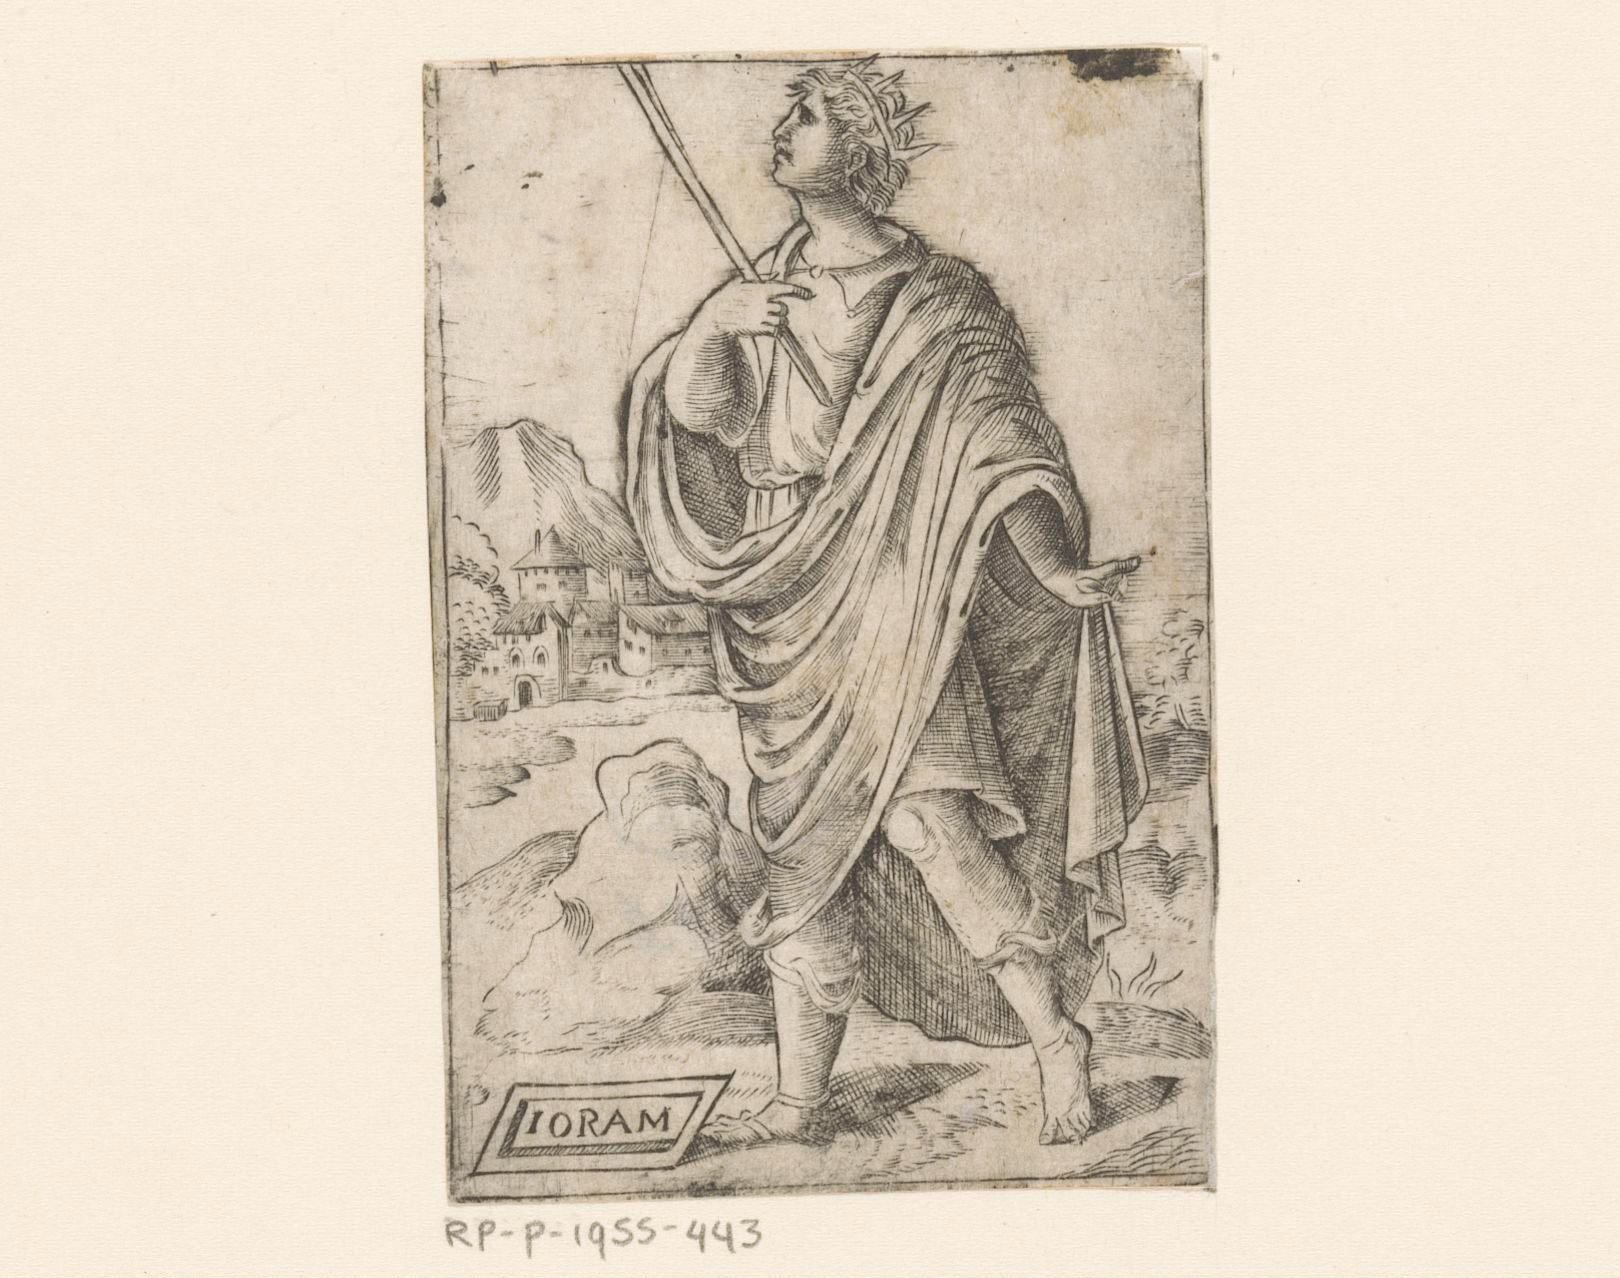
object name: print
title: Ioram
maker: Anonymous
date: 1500-1599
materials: paper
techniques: engraving, intaglio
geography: italy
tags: story of jehoram (joram), son of ahab, king of israel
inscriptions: collector's mark: Lugt 2228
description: Koning Joram van Israël staand in een landschap. Op zijn hoofd draagt hij een kroon en in zijn hand houdt hij een stok.